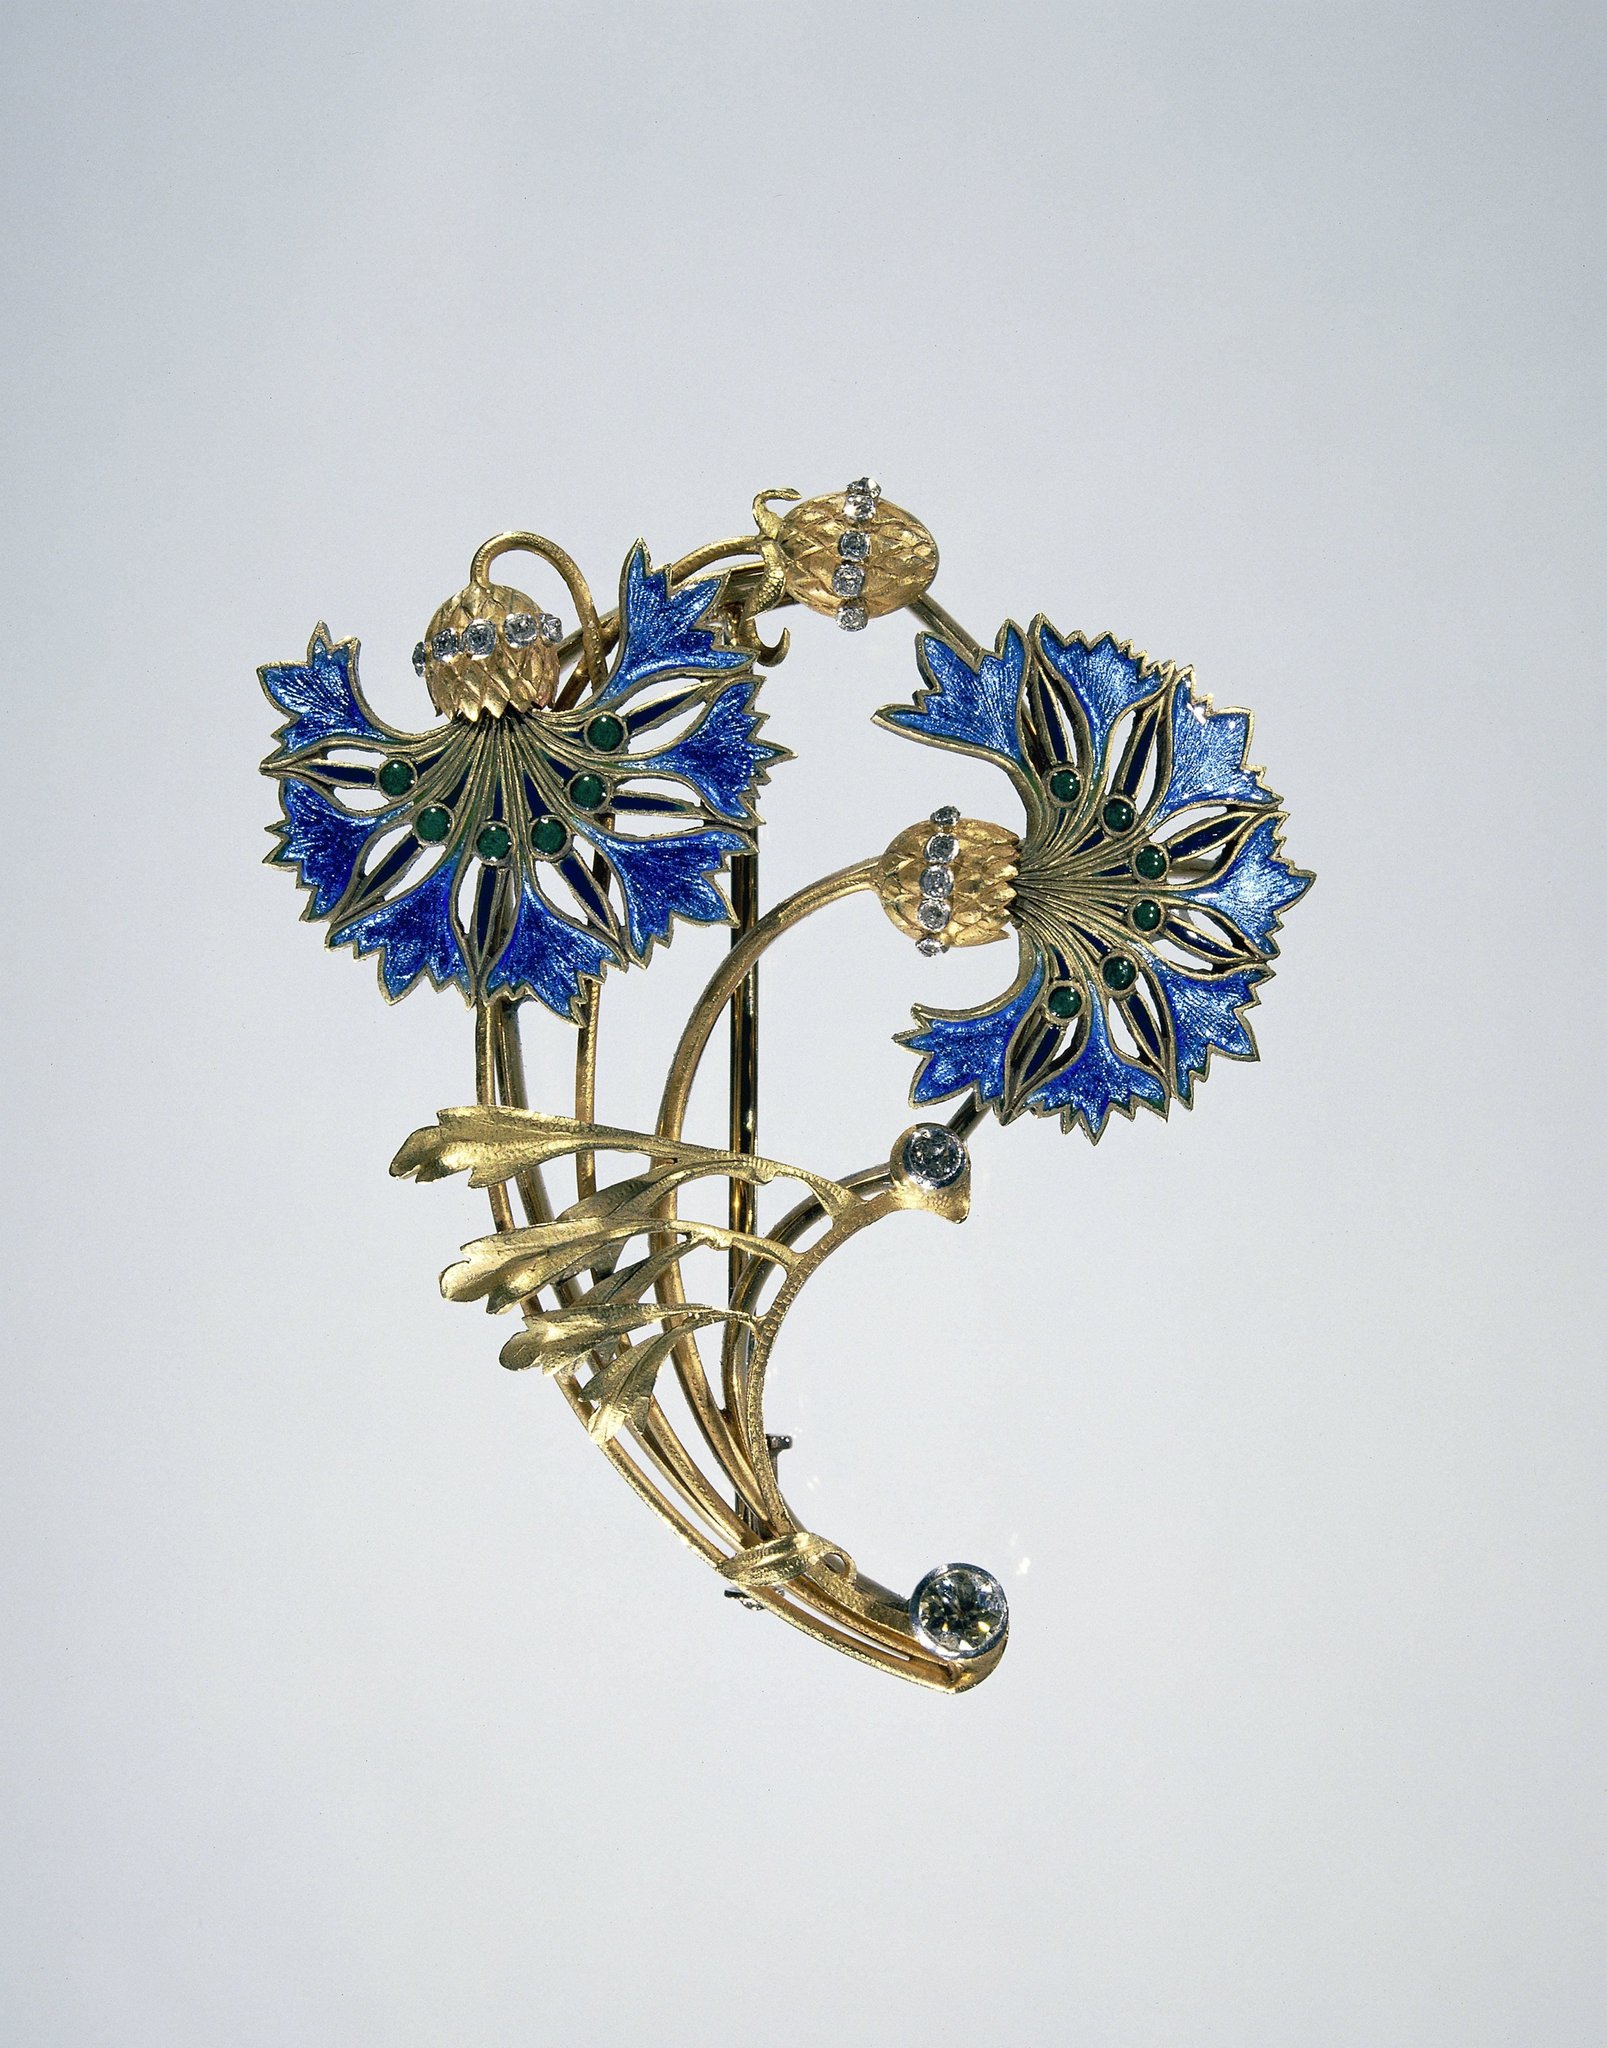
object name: jewellery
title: Broche van goud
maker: Anonymous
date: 1900-1910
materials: diamond, gold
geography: paris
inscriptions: alloy mark: ‘585 in ovaal (vanaf 1955)’, maker's mark: ‘W 2 G in achthoek’, alloy mark: ‘adelaarskop naar rechts (vanaf 1847)’, maker's mark: ‘V.R.’, mark: ‘M.D.’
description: Broche van goud, diamanten en email in de vorm van korenbloemen in art nouveau-stijl.